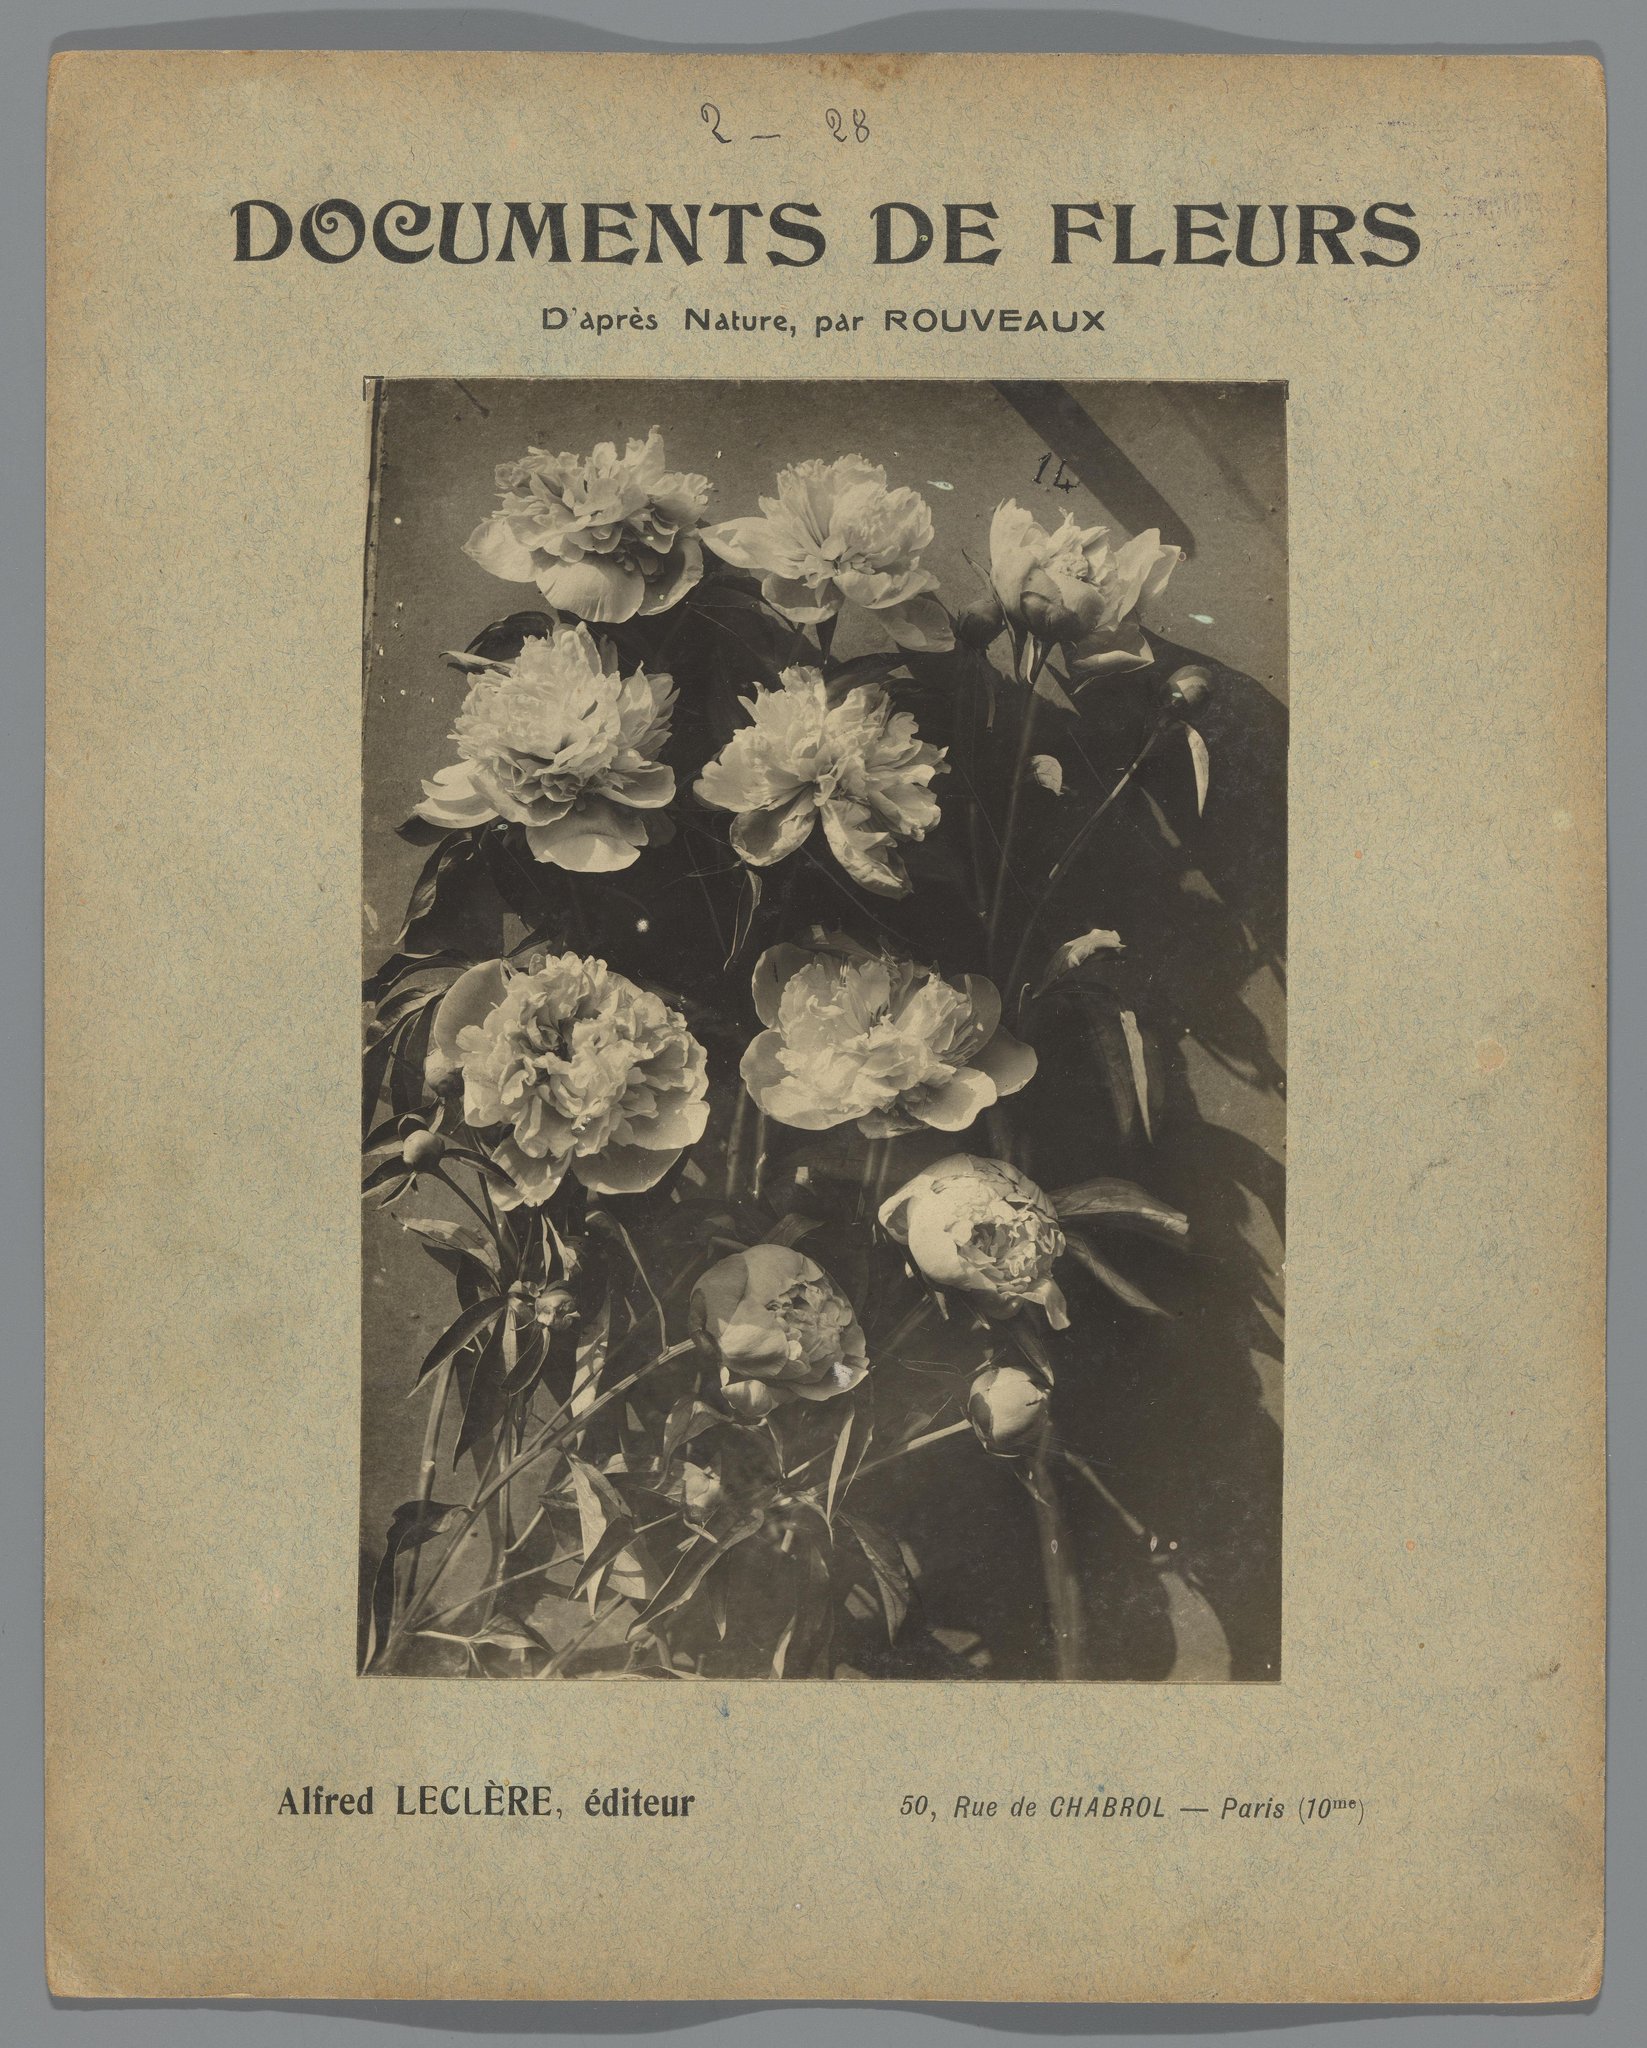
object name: photograph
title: Bloemstudie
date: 1895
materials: photographic support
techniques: gelatin silver print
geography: france